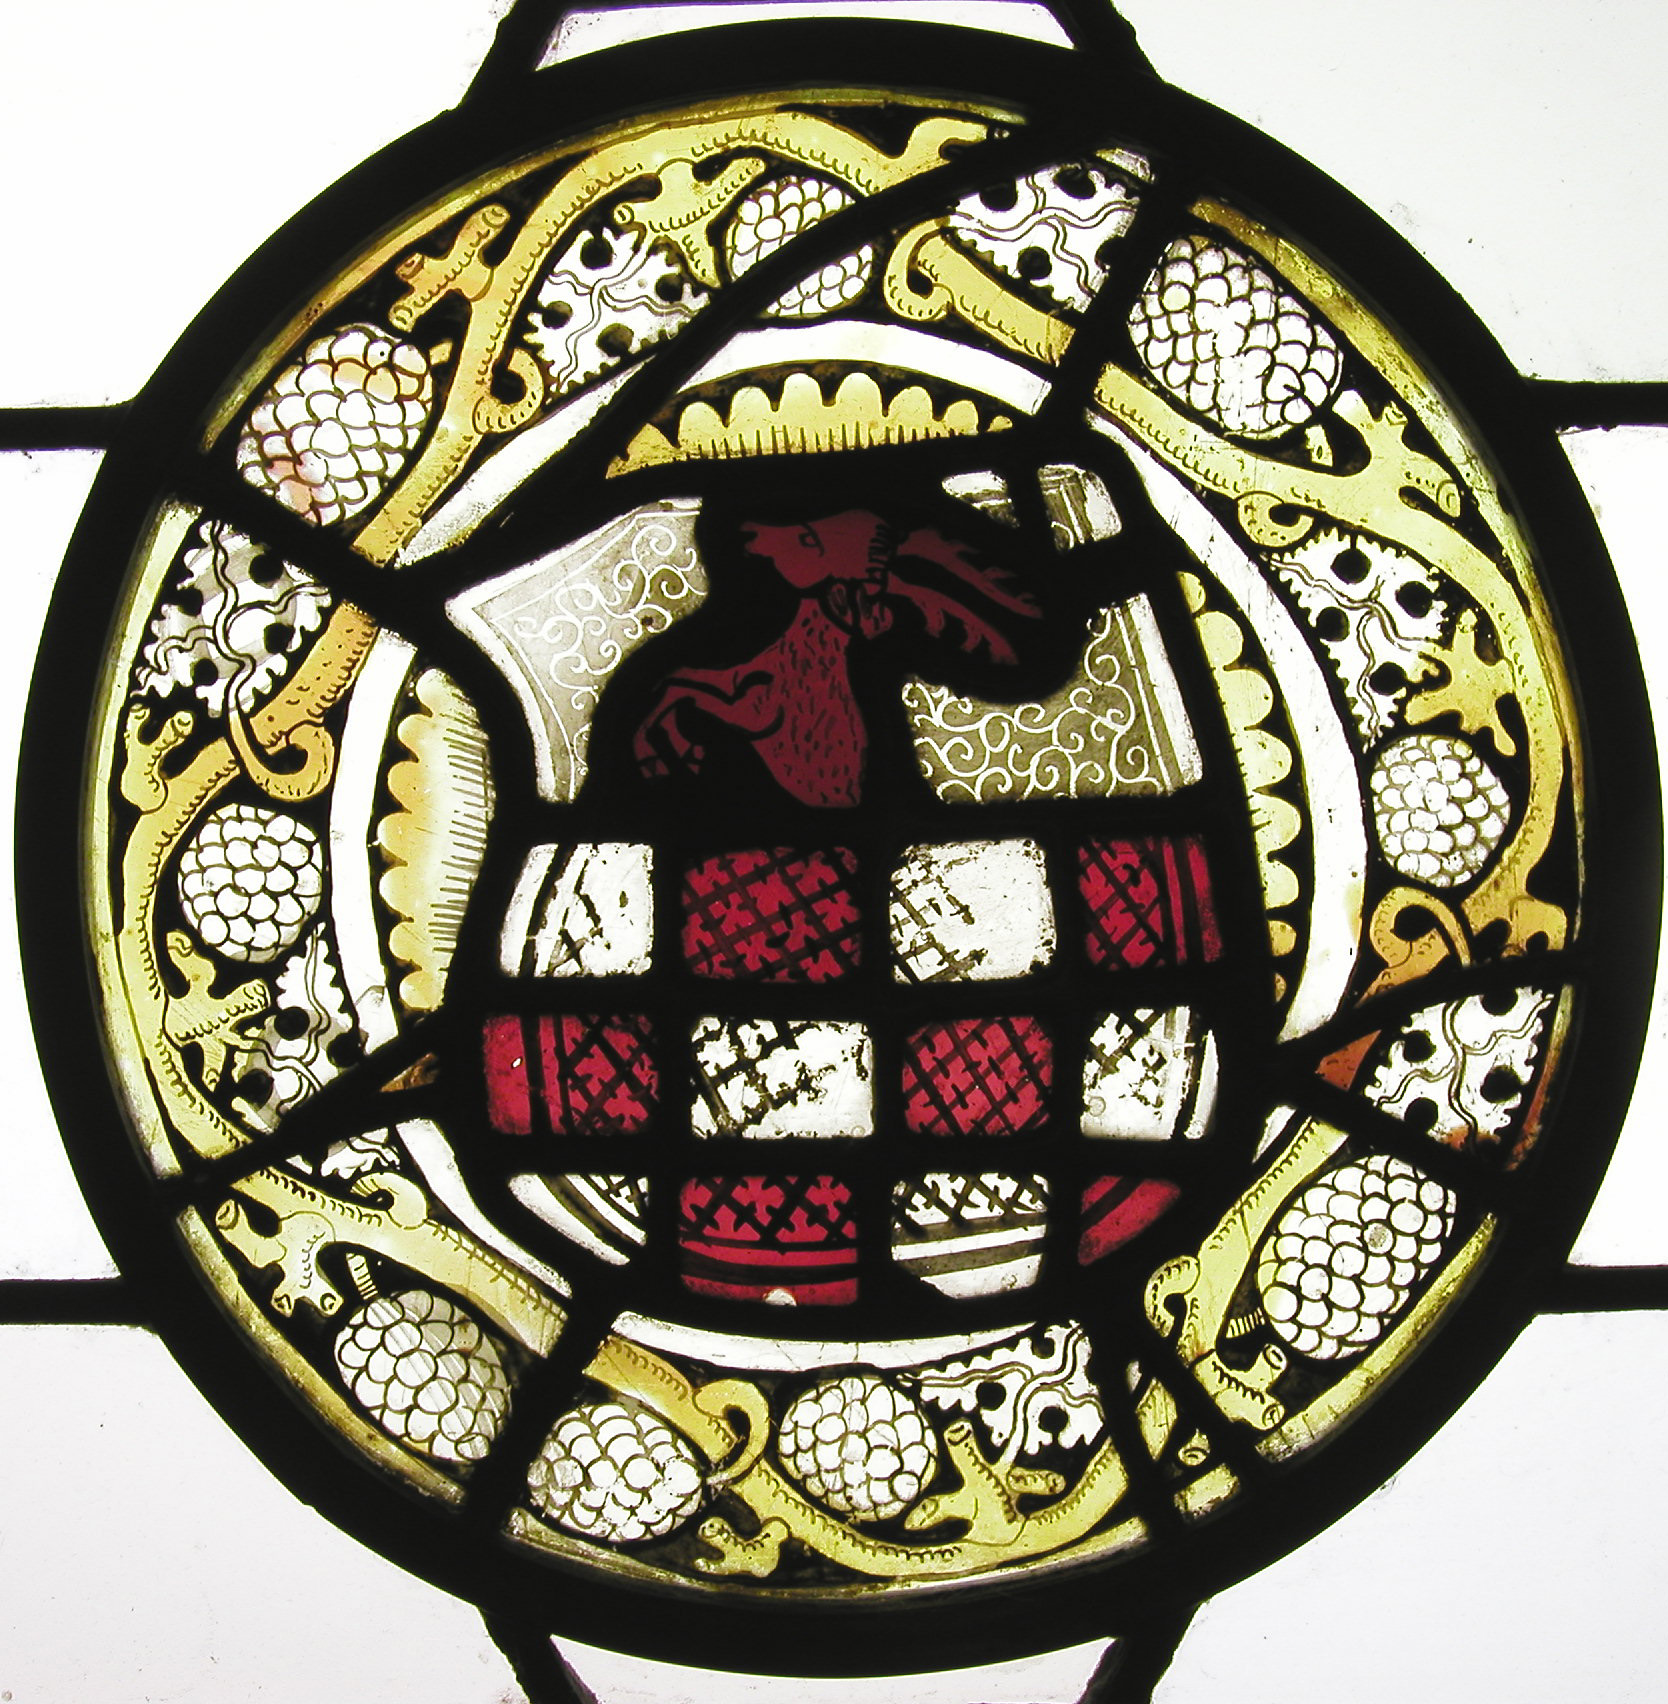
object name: roundel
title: Armorial Roundel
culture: german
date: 1500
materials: glass, metal, paint, pigment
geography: germany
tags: coat of arms